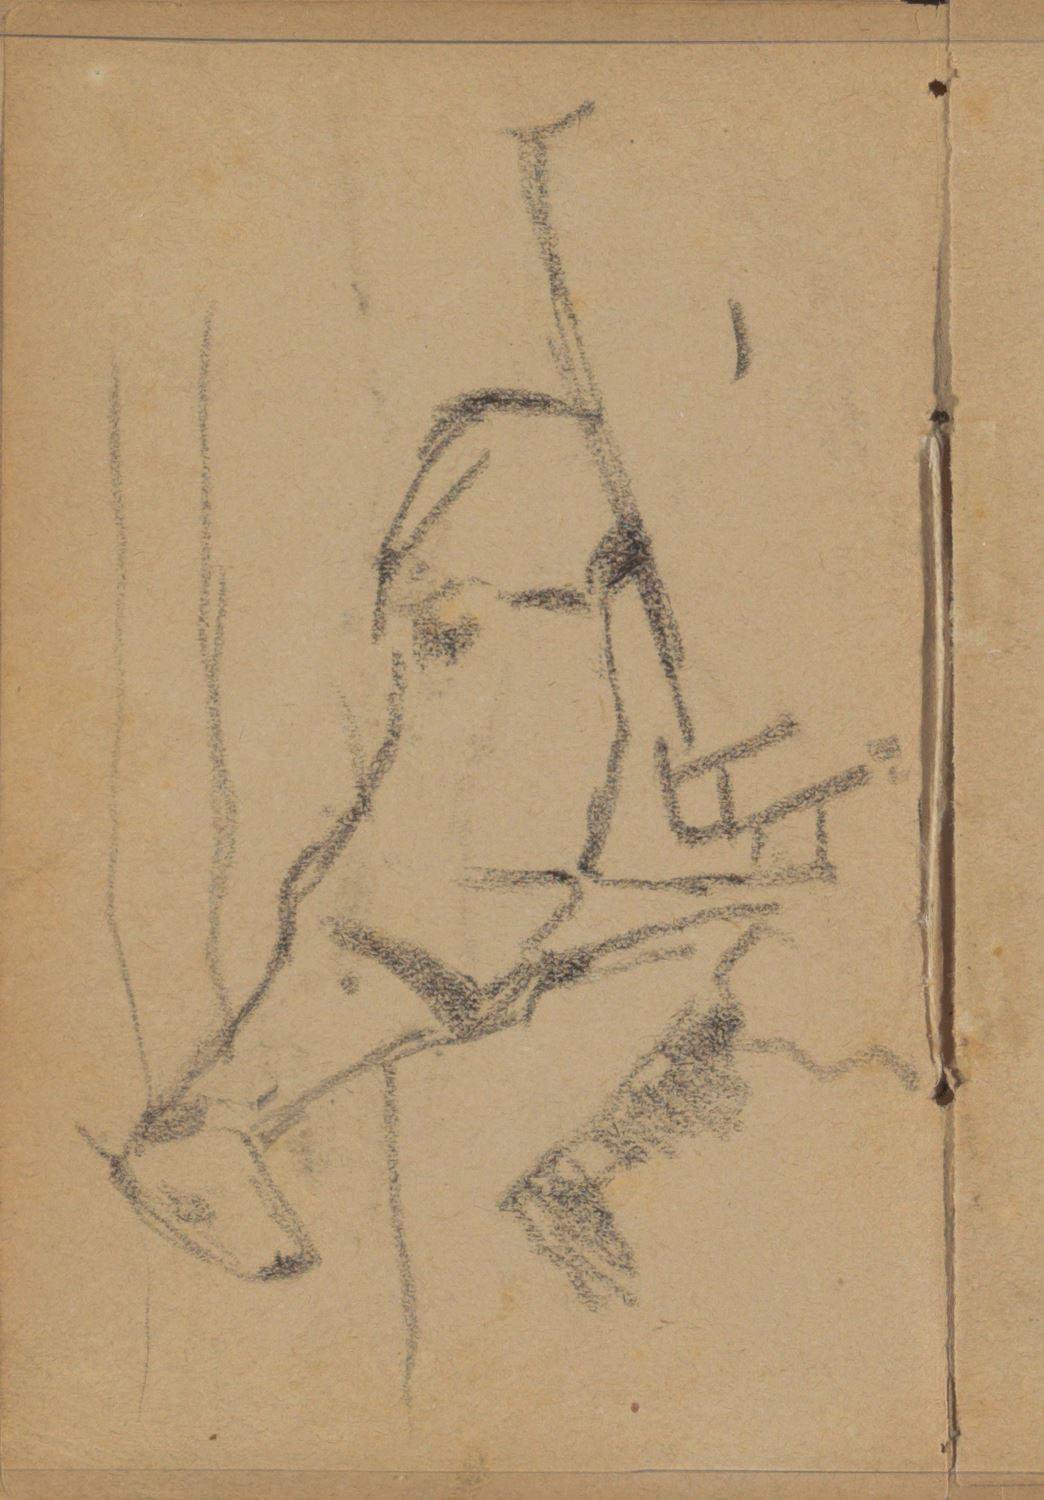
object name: sketchbook leaf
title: Paard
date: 1887-1891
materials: chalk, paper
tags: horse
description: Pagina 53 uit een schetsboek met 83 bladen.